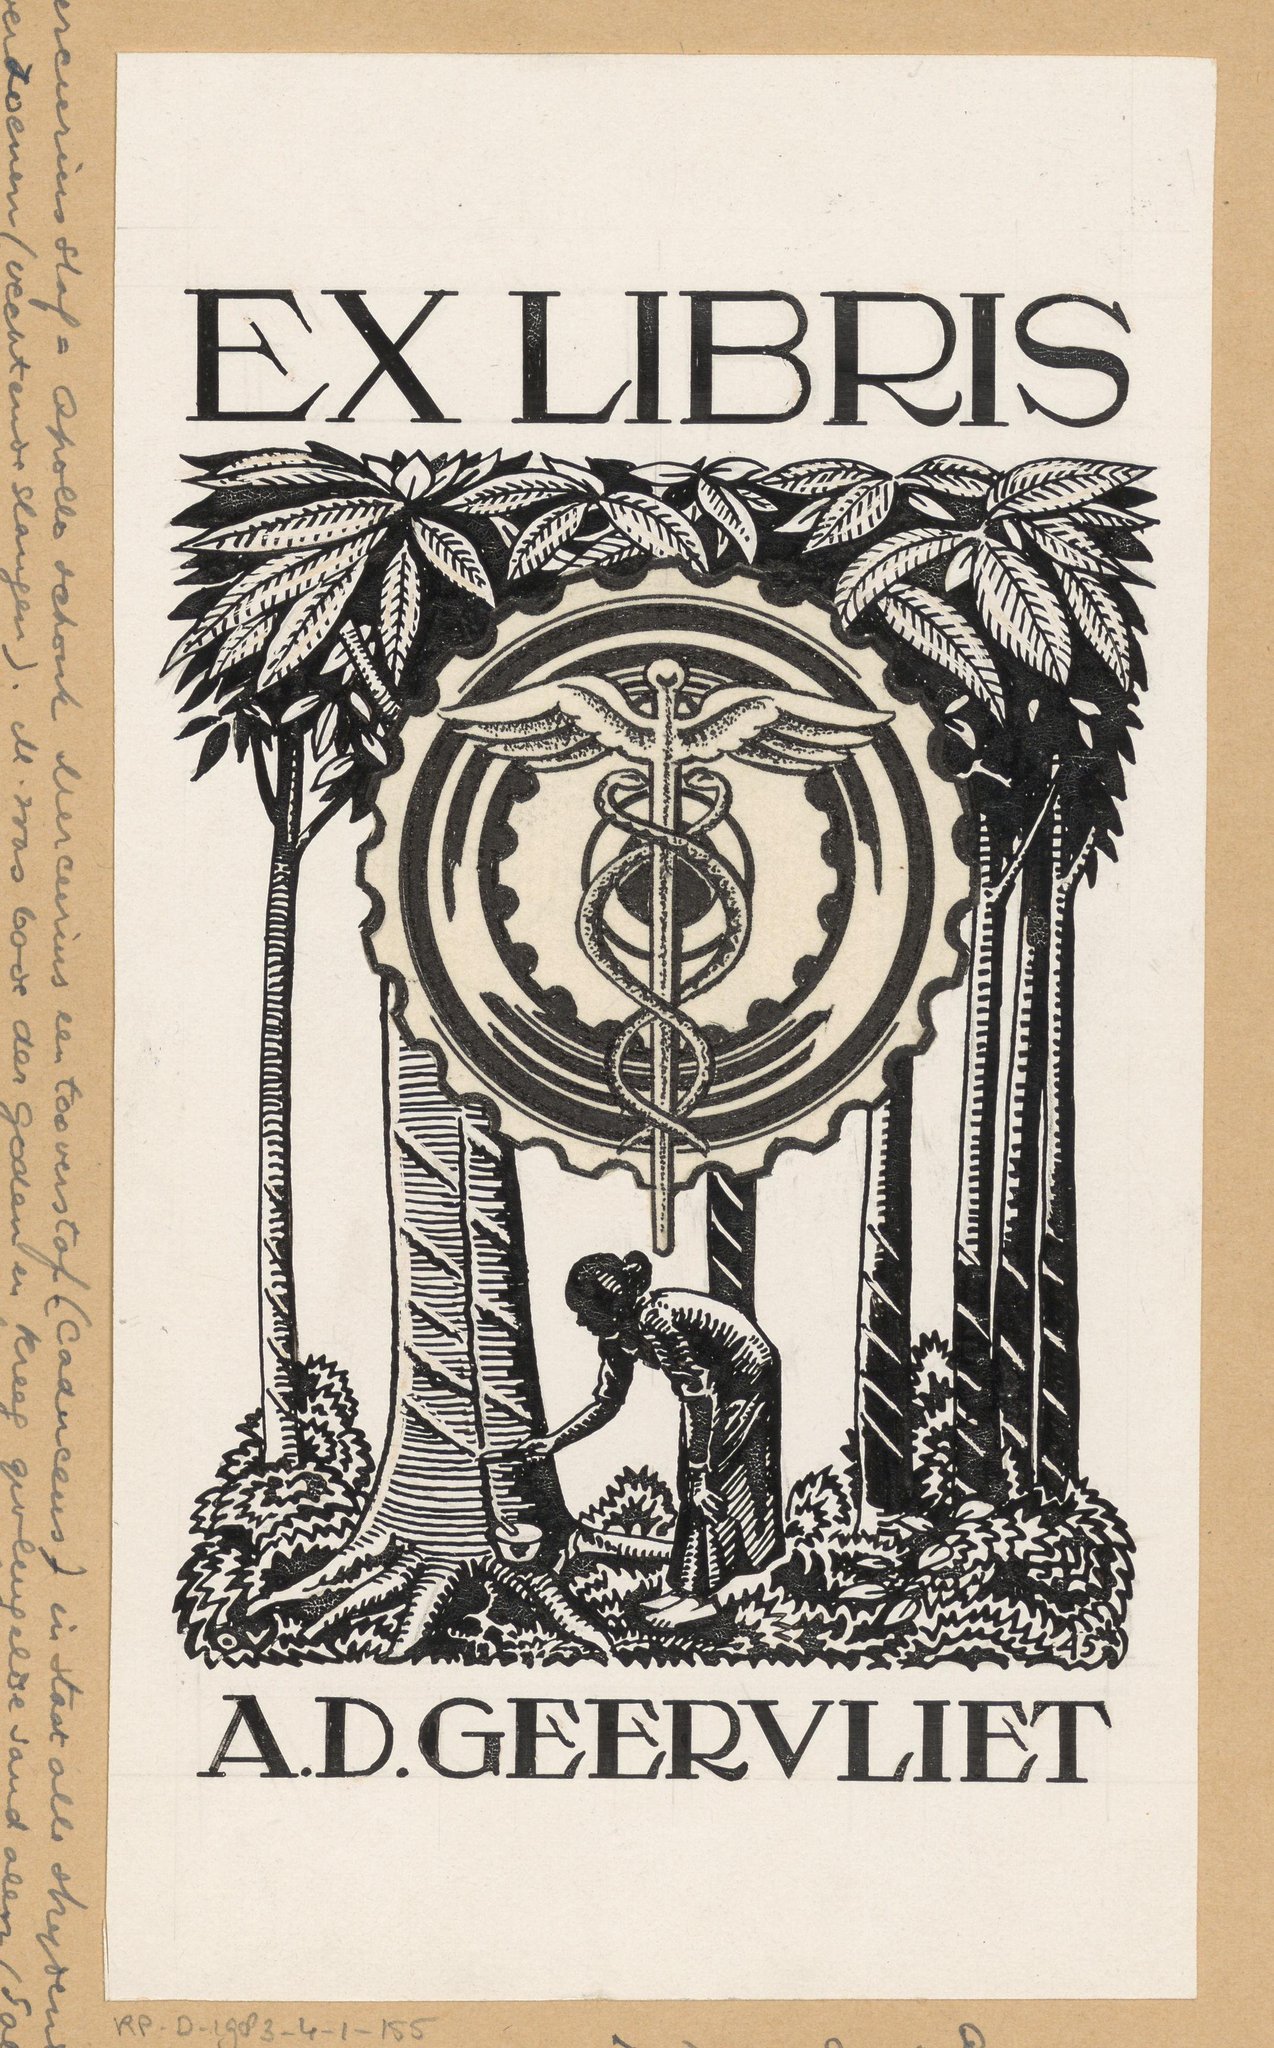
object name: design drawing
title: Ex libris A.D. Geervliet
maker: otto verhagen (i)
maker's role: draughtsman, print maker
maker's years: 1885-1951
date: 1945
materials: ink, paper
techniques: drawing, pen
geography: netherlands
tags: trees, caduceus (staff with two snakes, attribute of mercury)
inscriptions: inscription: ‘Afgekeurd/ ontwerp/ meer/ geschikt/ voor/ een/ rubber-/ planter’, inscription: ‘Mercuriusstaf = appollo (...) = philatelie, 1945’